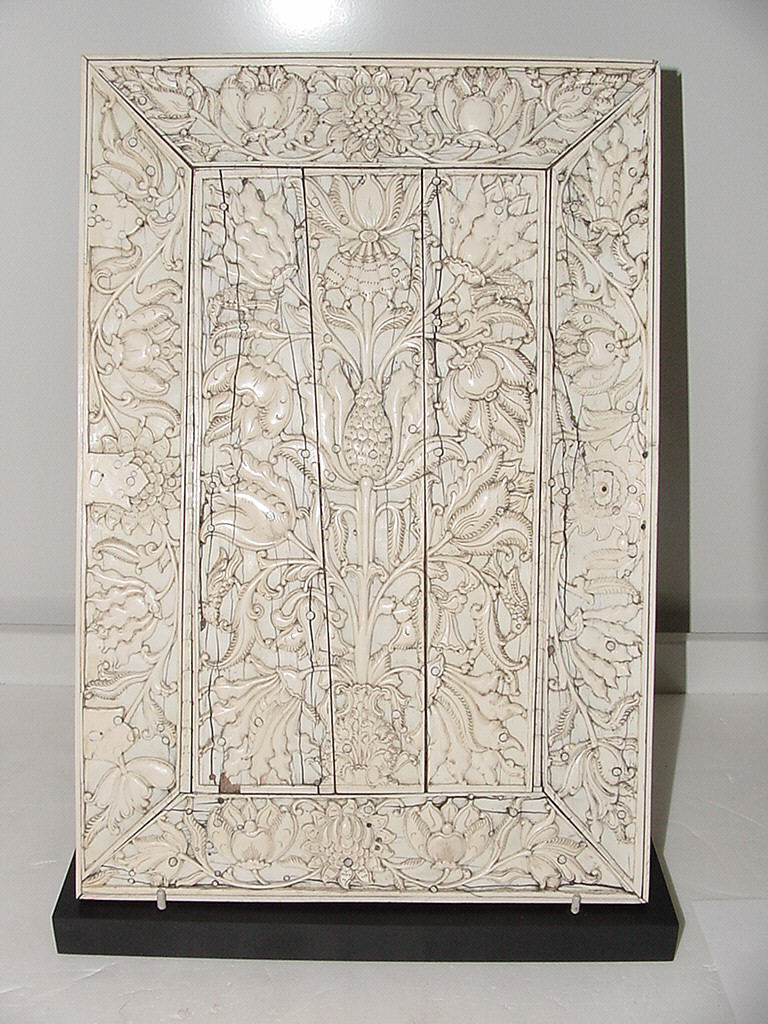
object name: panel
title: Ivory Panel from a Cabinet with Flowers and Birds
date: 1667-1700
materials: ivory, wood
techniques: veneering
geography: india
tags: birds,flowers